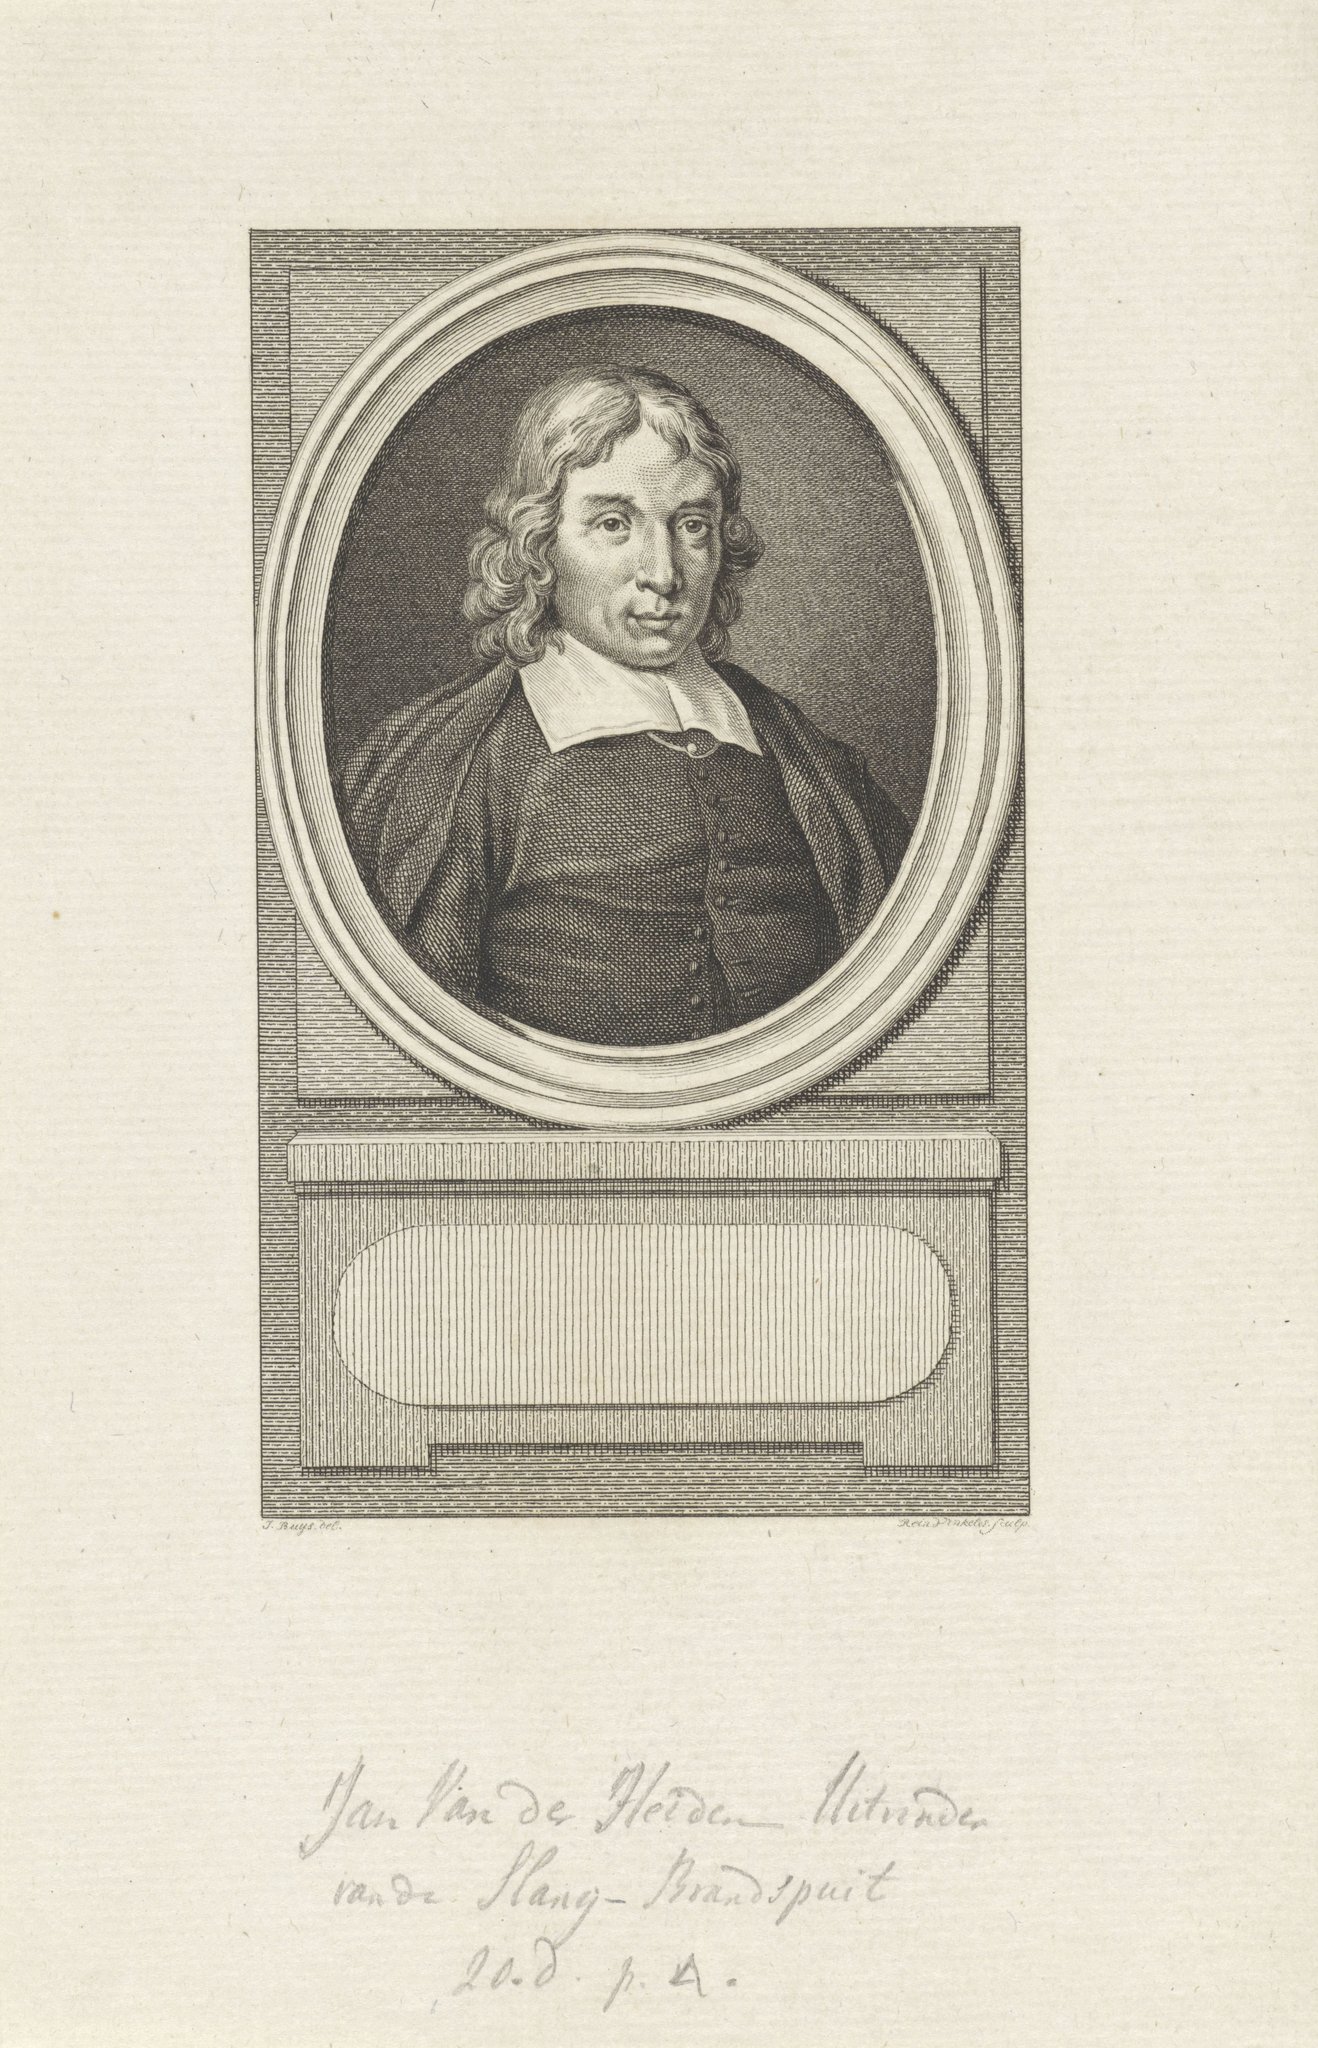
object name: print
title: Portret van Jan van der Heyden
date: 1789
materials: paper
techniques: engraving, etching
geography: amsterdam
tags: painter, print maker, draughtsman, jan van der heyden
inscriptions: inscription: ‘Jan van de Heiden Uitvinder/ van de Slang-brandspuit/ 20 d. p. 4’, collector's mark: Lugt 240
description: Latere staat prent gebruikt als boekillustratie in: Kok, Jacobus. Vaderlandsch woordenboek : met kaarten, plaaten en pourtraitten. Amsterdam: Johannes Allart, 1785-1796. Deel XX.